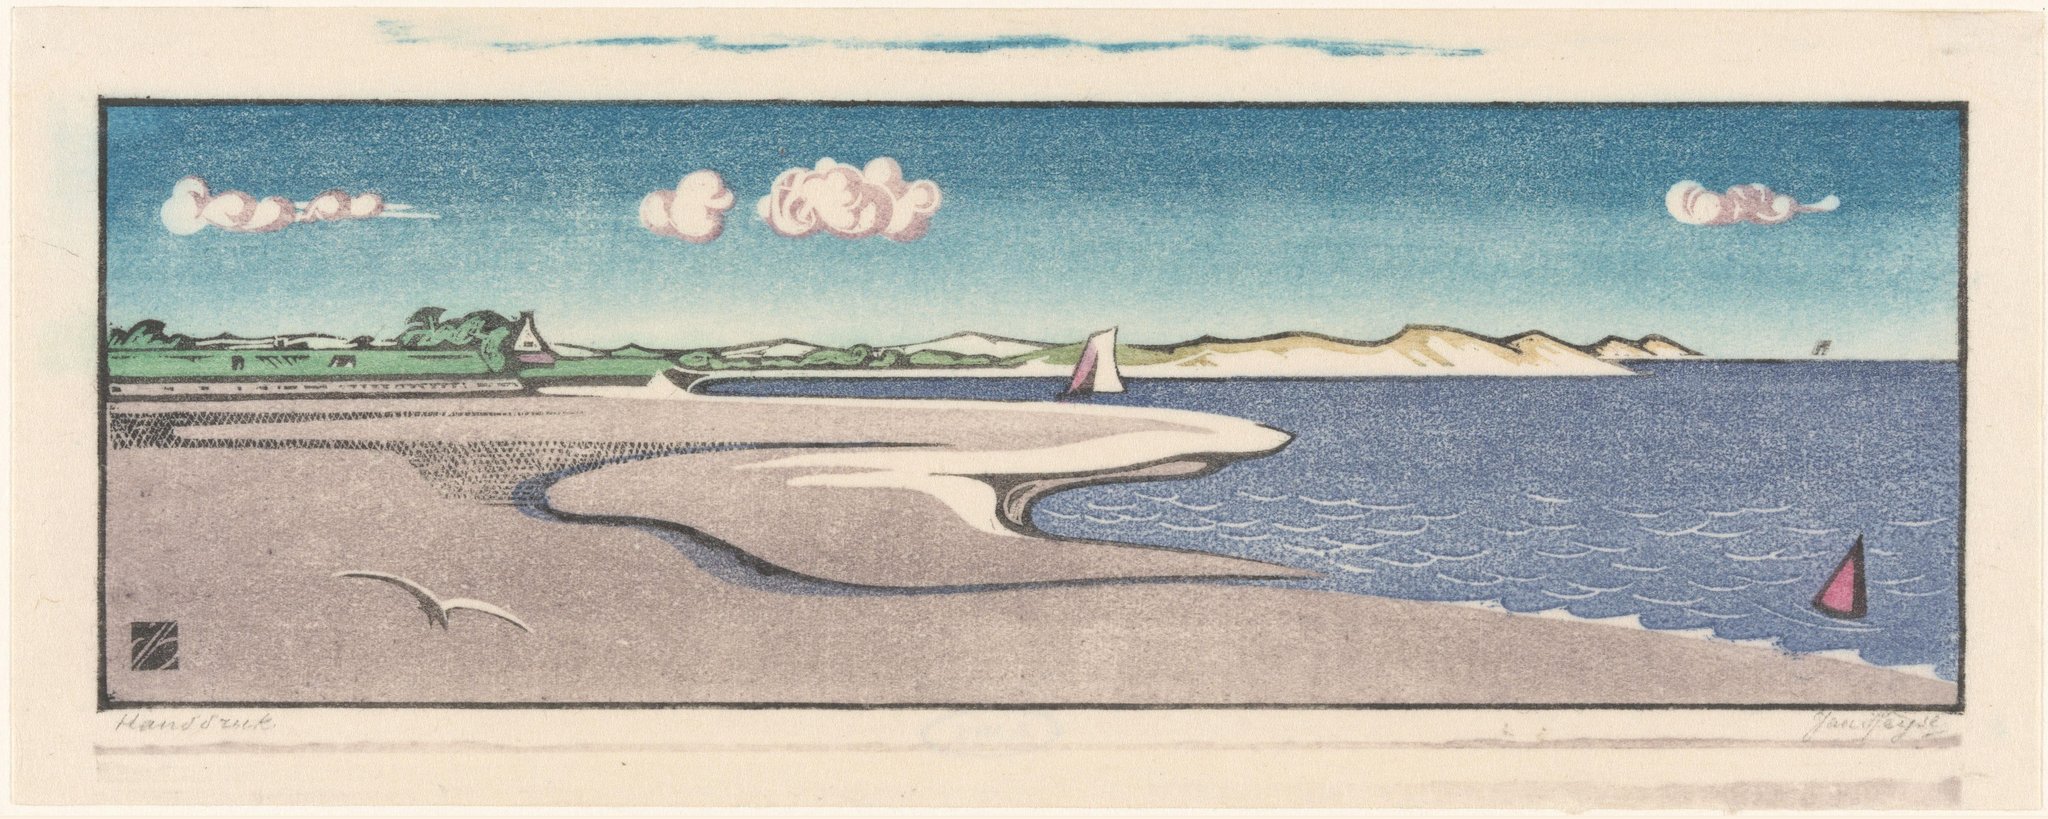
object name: print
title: Kustlandschap op Walcheren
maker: jan heyse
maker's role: painter, print maker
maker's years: 1882-1954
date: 1892-1931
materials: paper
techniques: woodcut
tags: coast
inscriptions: collector's mark: Lugt 2228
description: Rechts water met twee zeilboten, mogelijk het Veerse Gat. Links een strand en op de achtergrond een weiland met koeien.